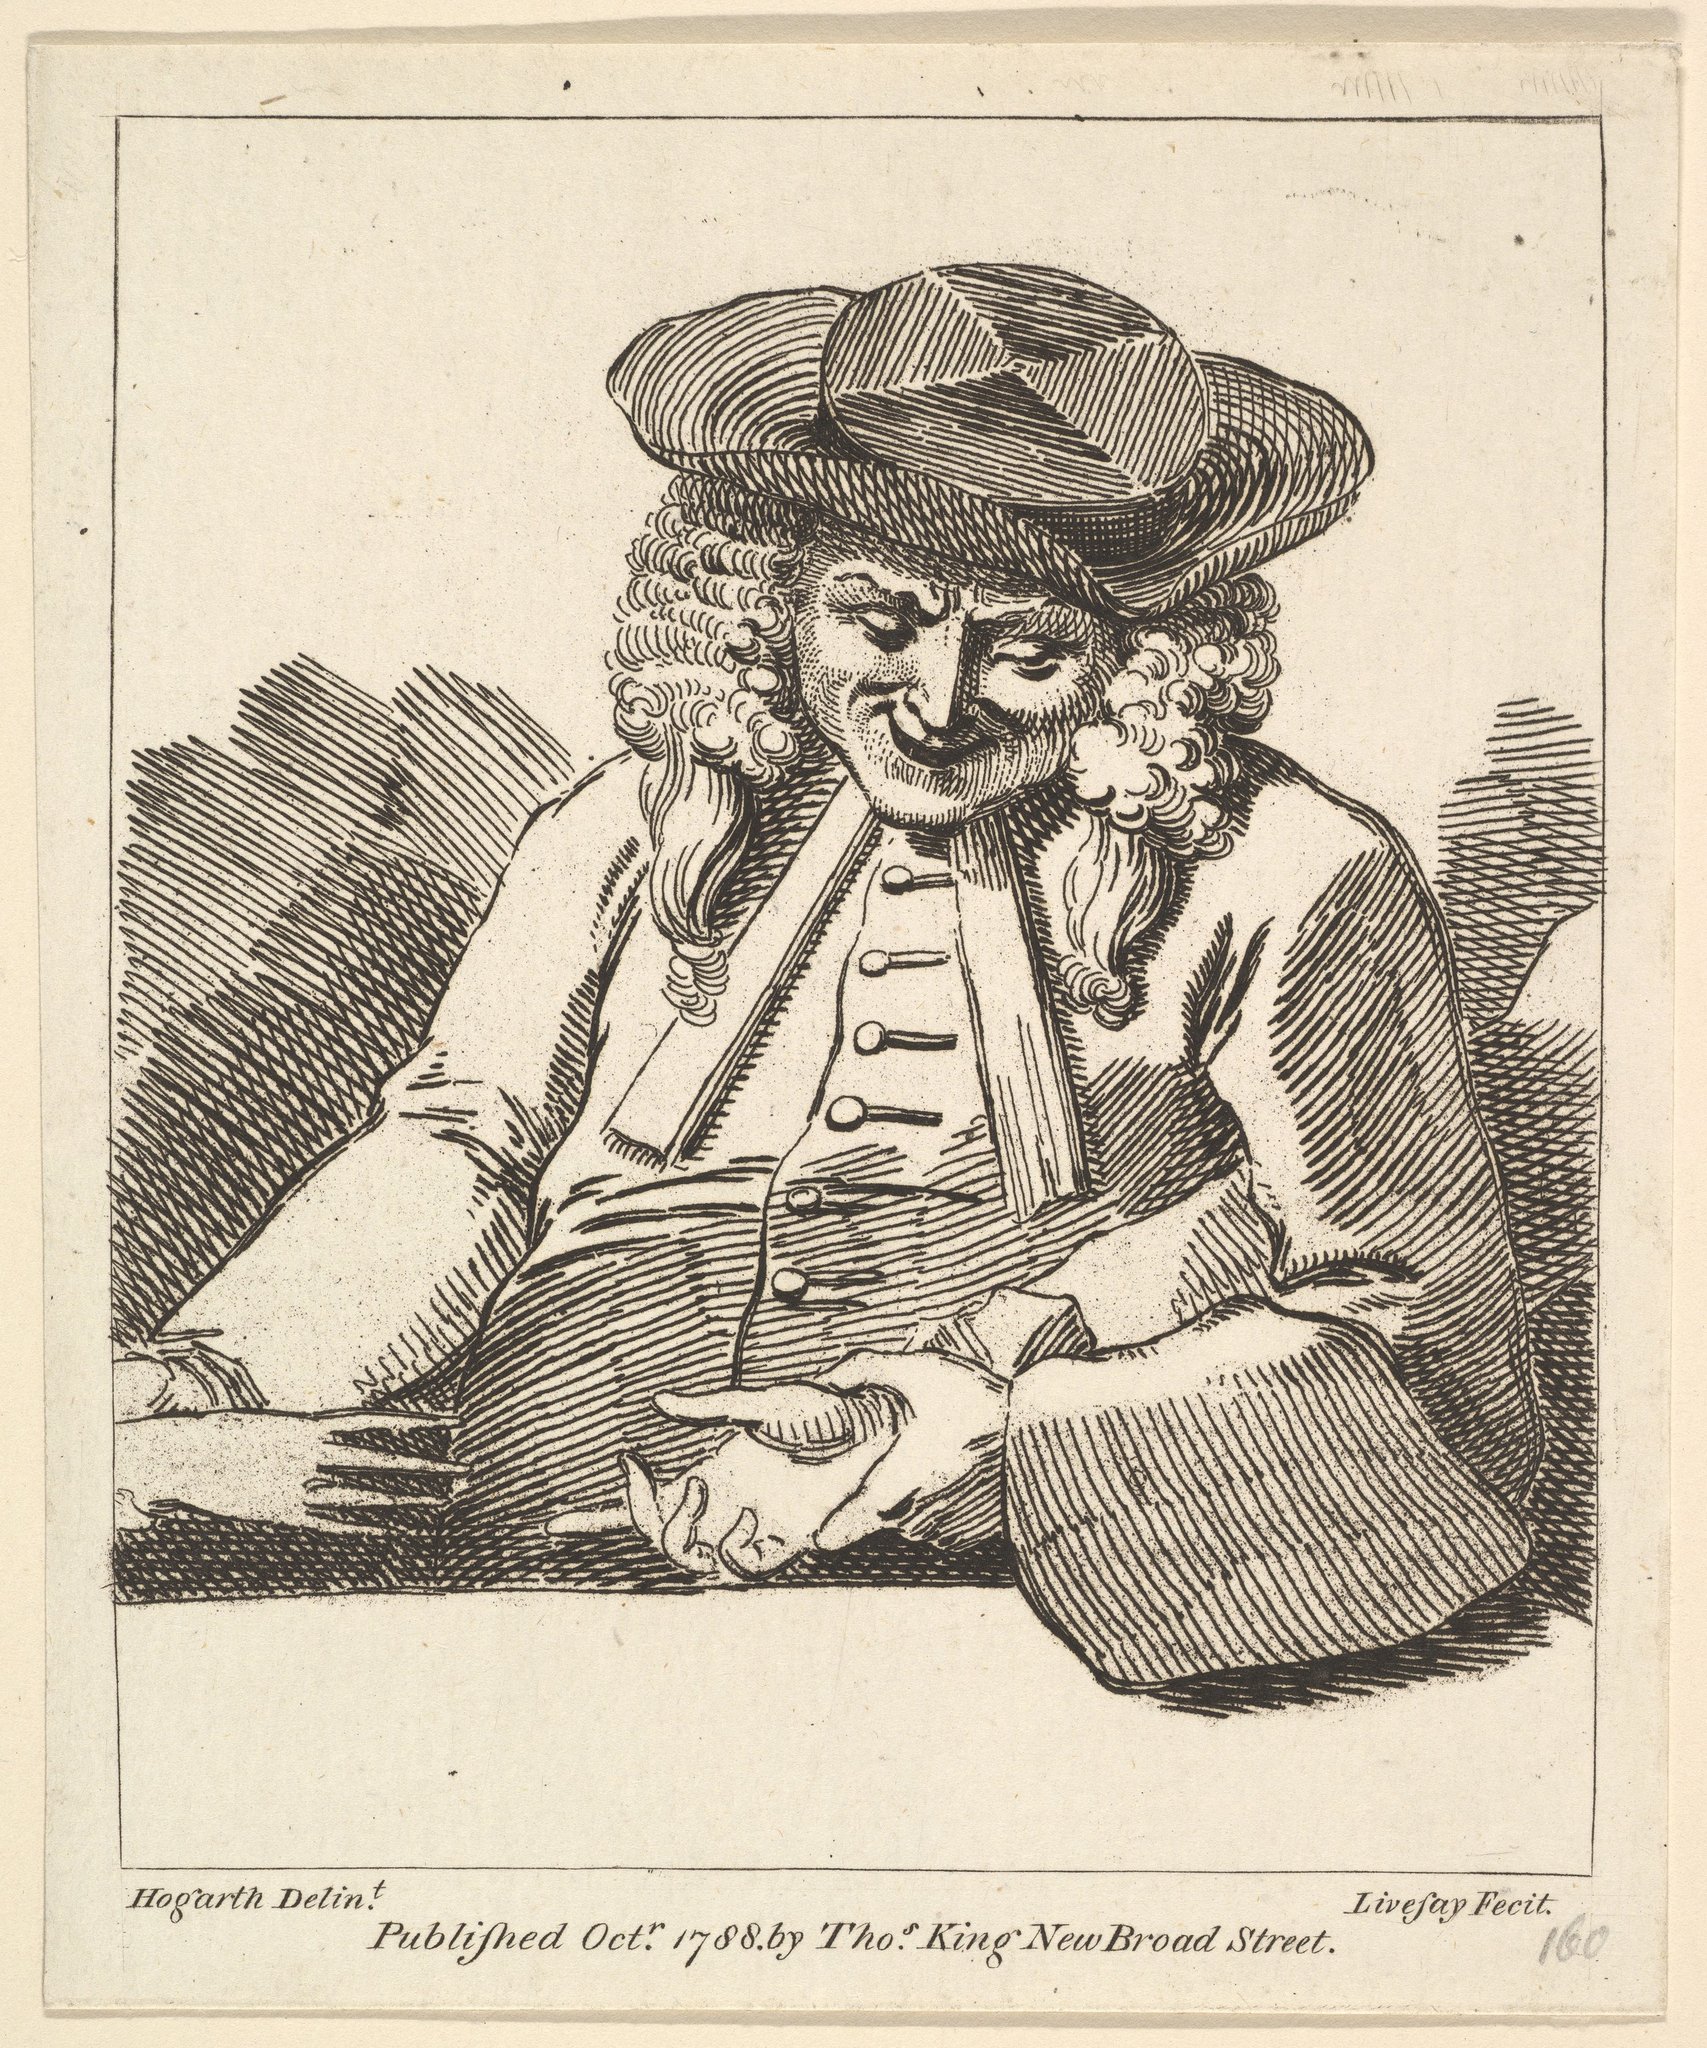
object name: print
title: A Parson Joining the Hands of Two People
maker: richard livesay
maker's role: etcher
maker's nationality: british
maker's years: 1750-1826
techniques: etching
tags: hands,men